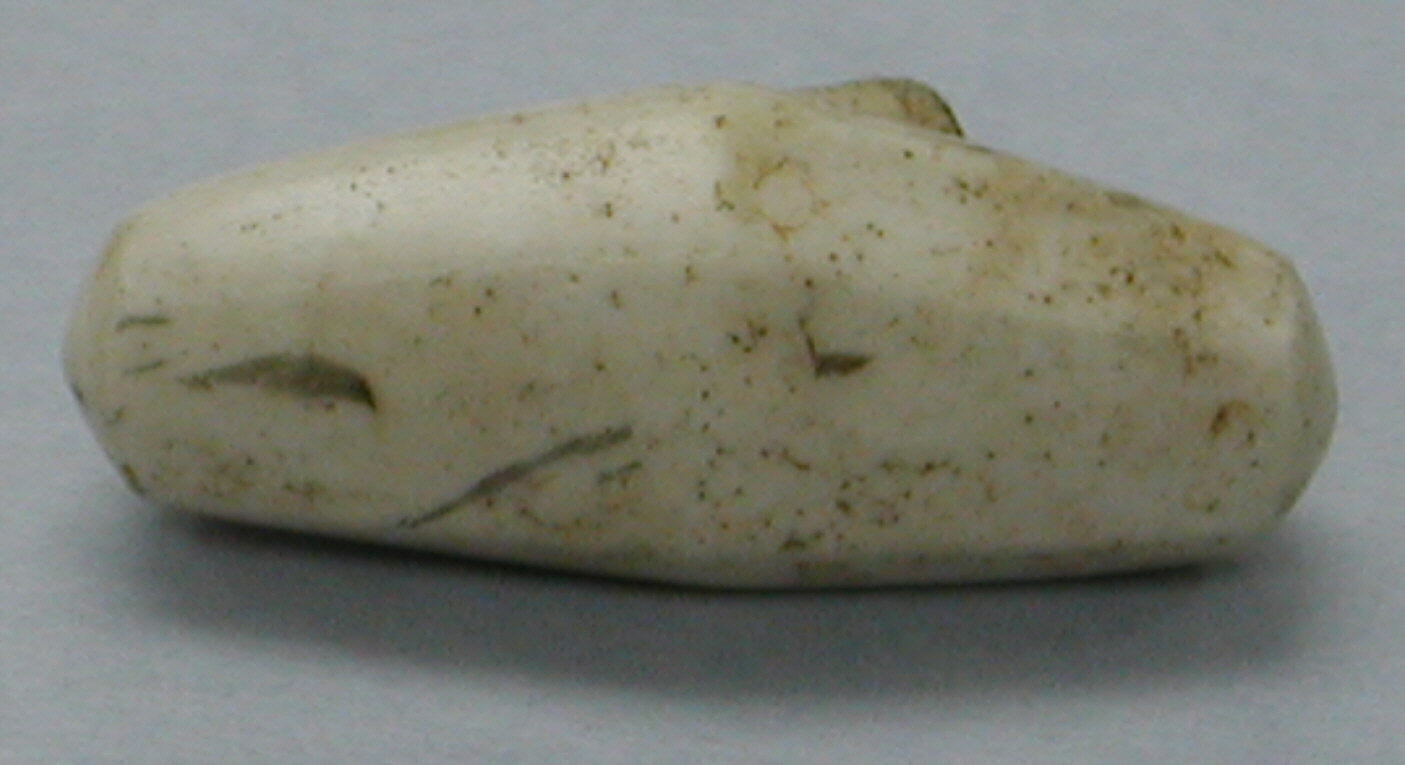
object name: ritual stone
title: Stone Pulidor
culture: mexican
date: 1501-1600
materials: stone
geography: mexico